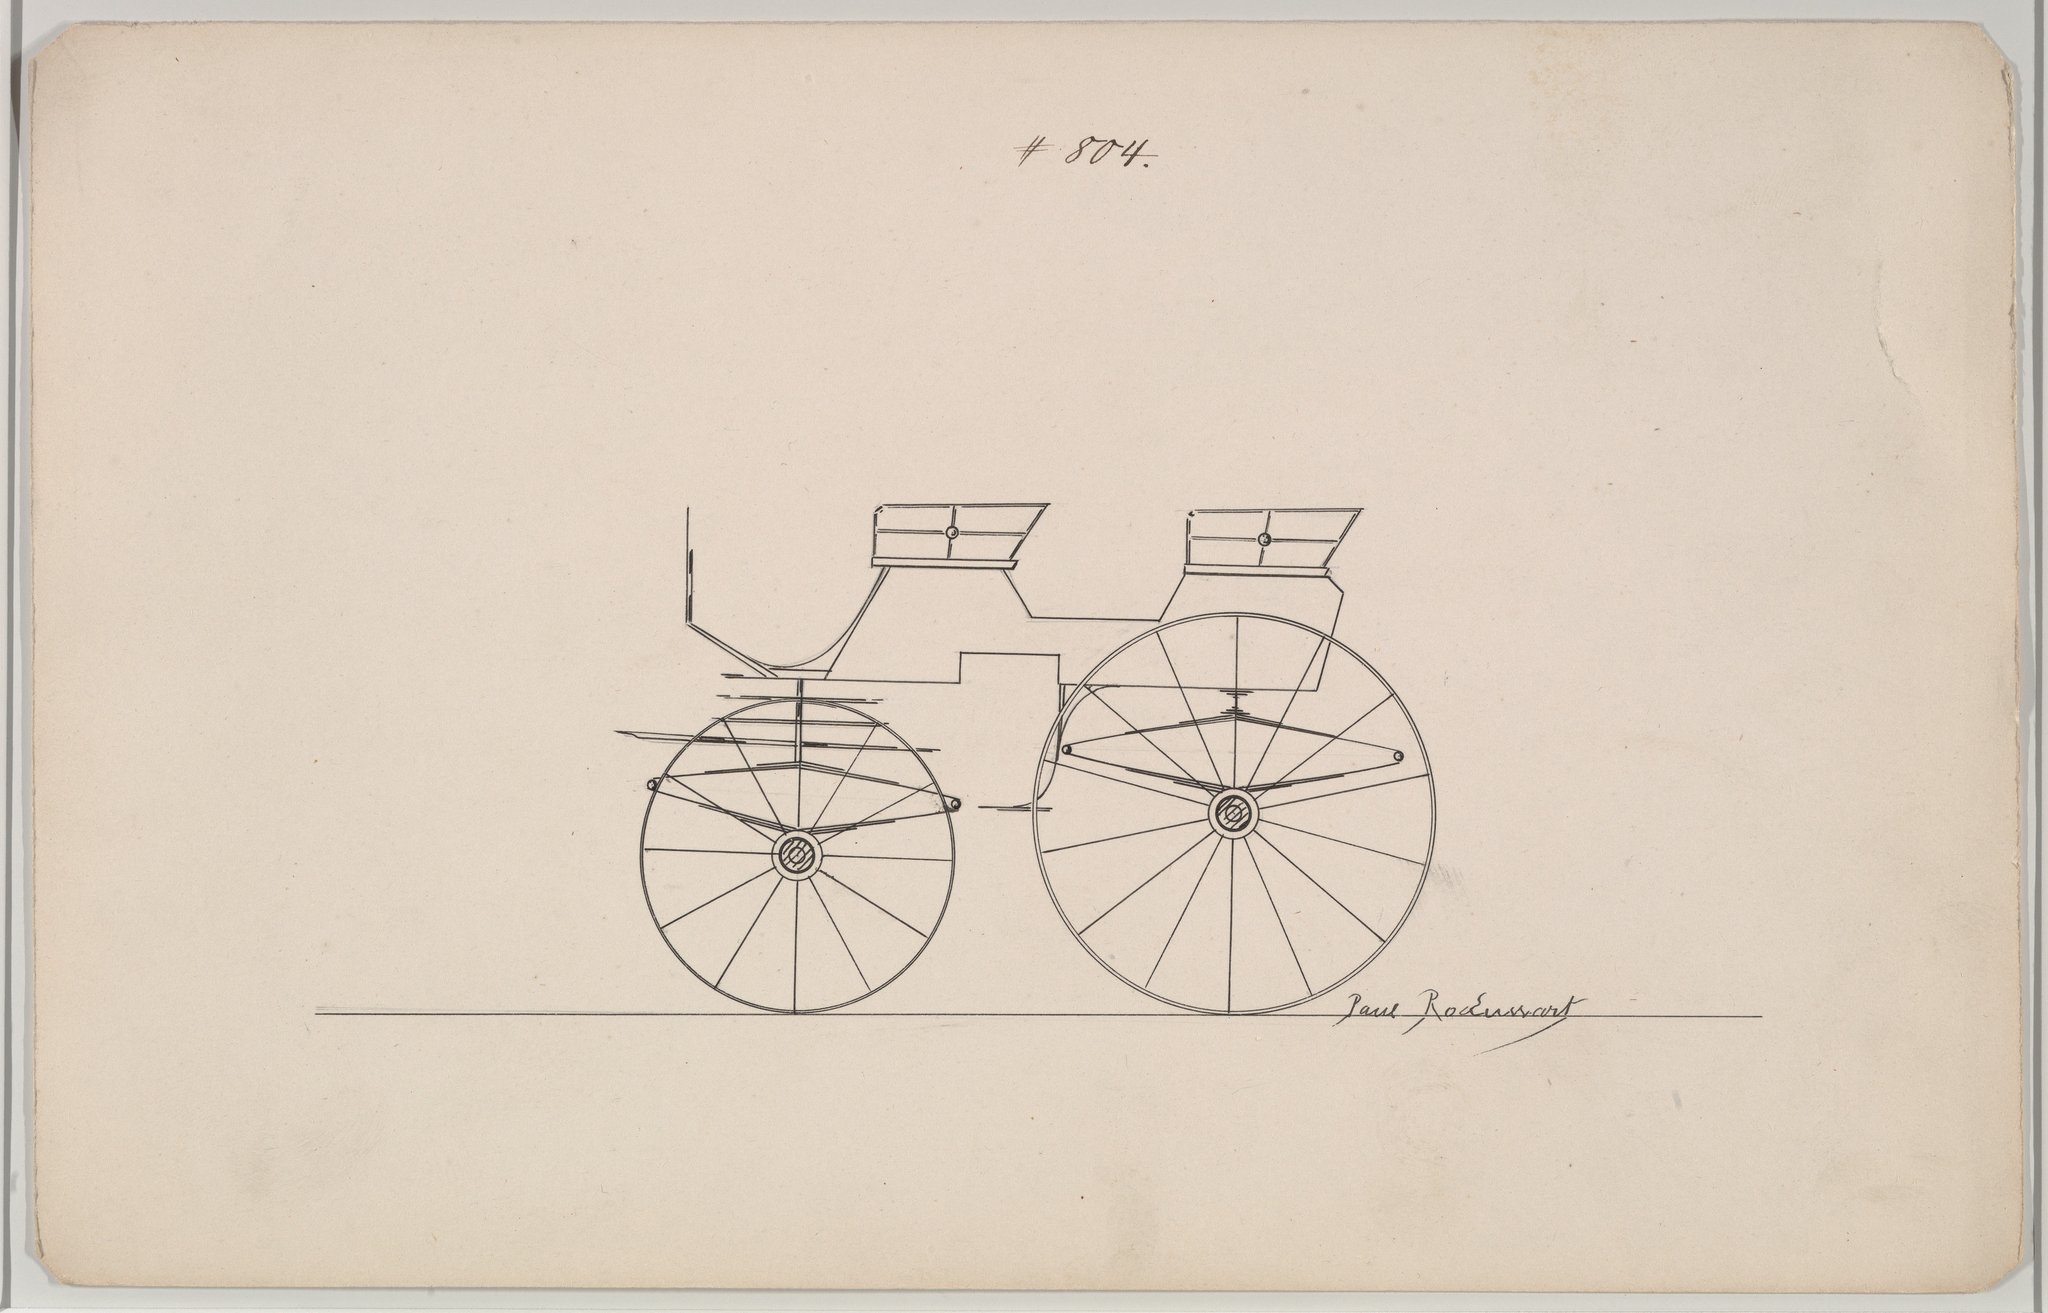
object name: drawing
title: Phaeton #804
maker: brewster & co.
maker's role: manufacturer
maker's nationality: american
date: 1850-1870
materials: ink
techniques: pen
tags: carriages